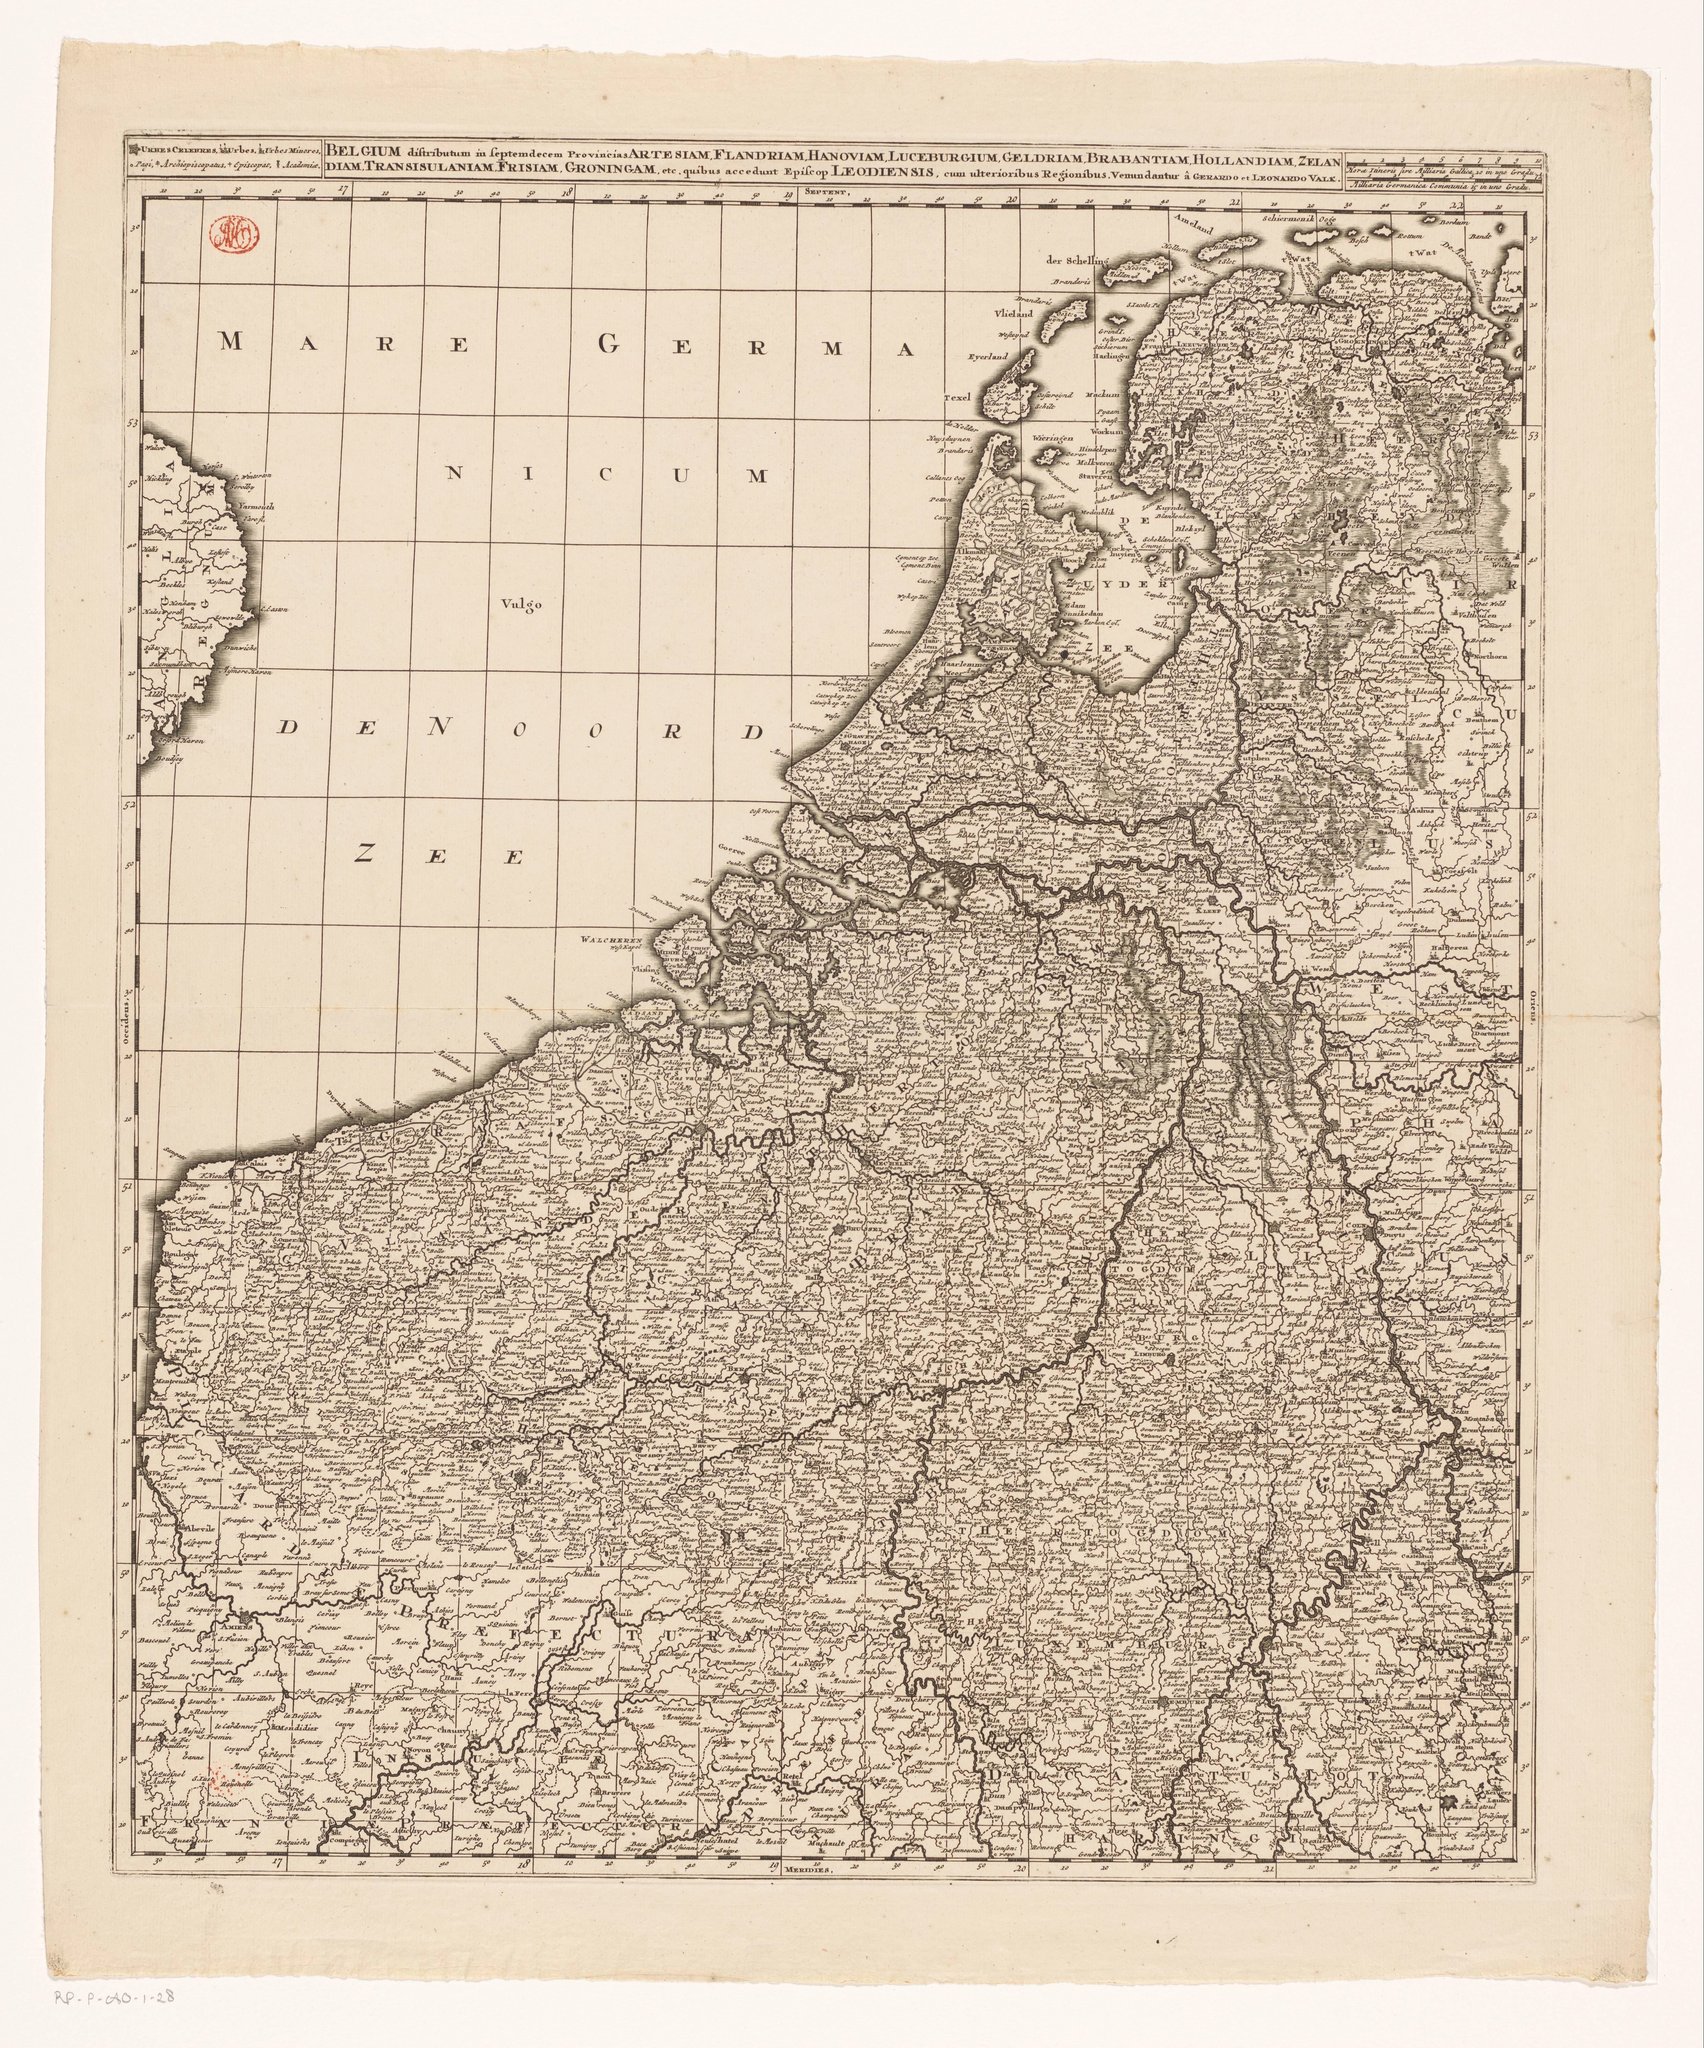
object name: map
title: Belgium distributum in septemdecem Provincias (...)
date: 1702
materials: paper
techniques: etching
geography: amsterdam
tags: maps of separate countries or regions, netherlands, belgium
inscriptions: collector's mark: Lugt 195, collector's mark: Lugt 2228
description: Kaart van de Zeventien Provinciën. Links een legenda. Rechts van de titel twee schaalstokken: Milliaria Gallica en Milliaria Germanica communia. Langs de randen een gradenverdeling. De prent is voorzien van een coördinaten-net. In de rand de namen van de windrichtingen.